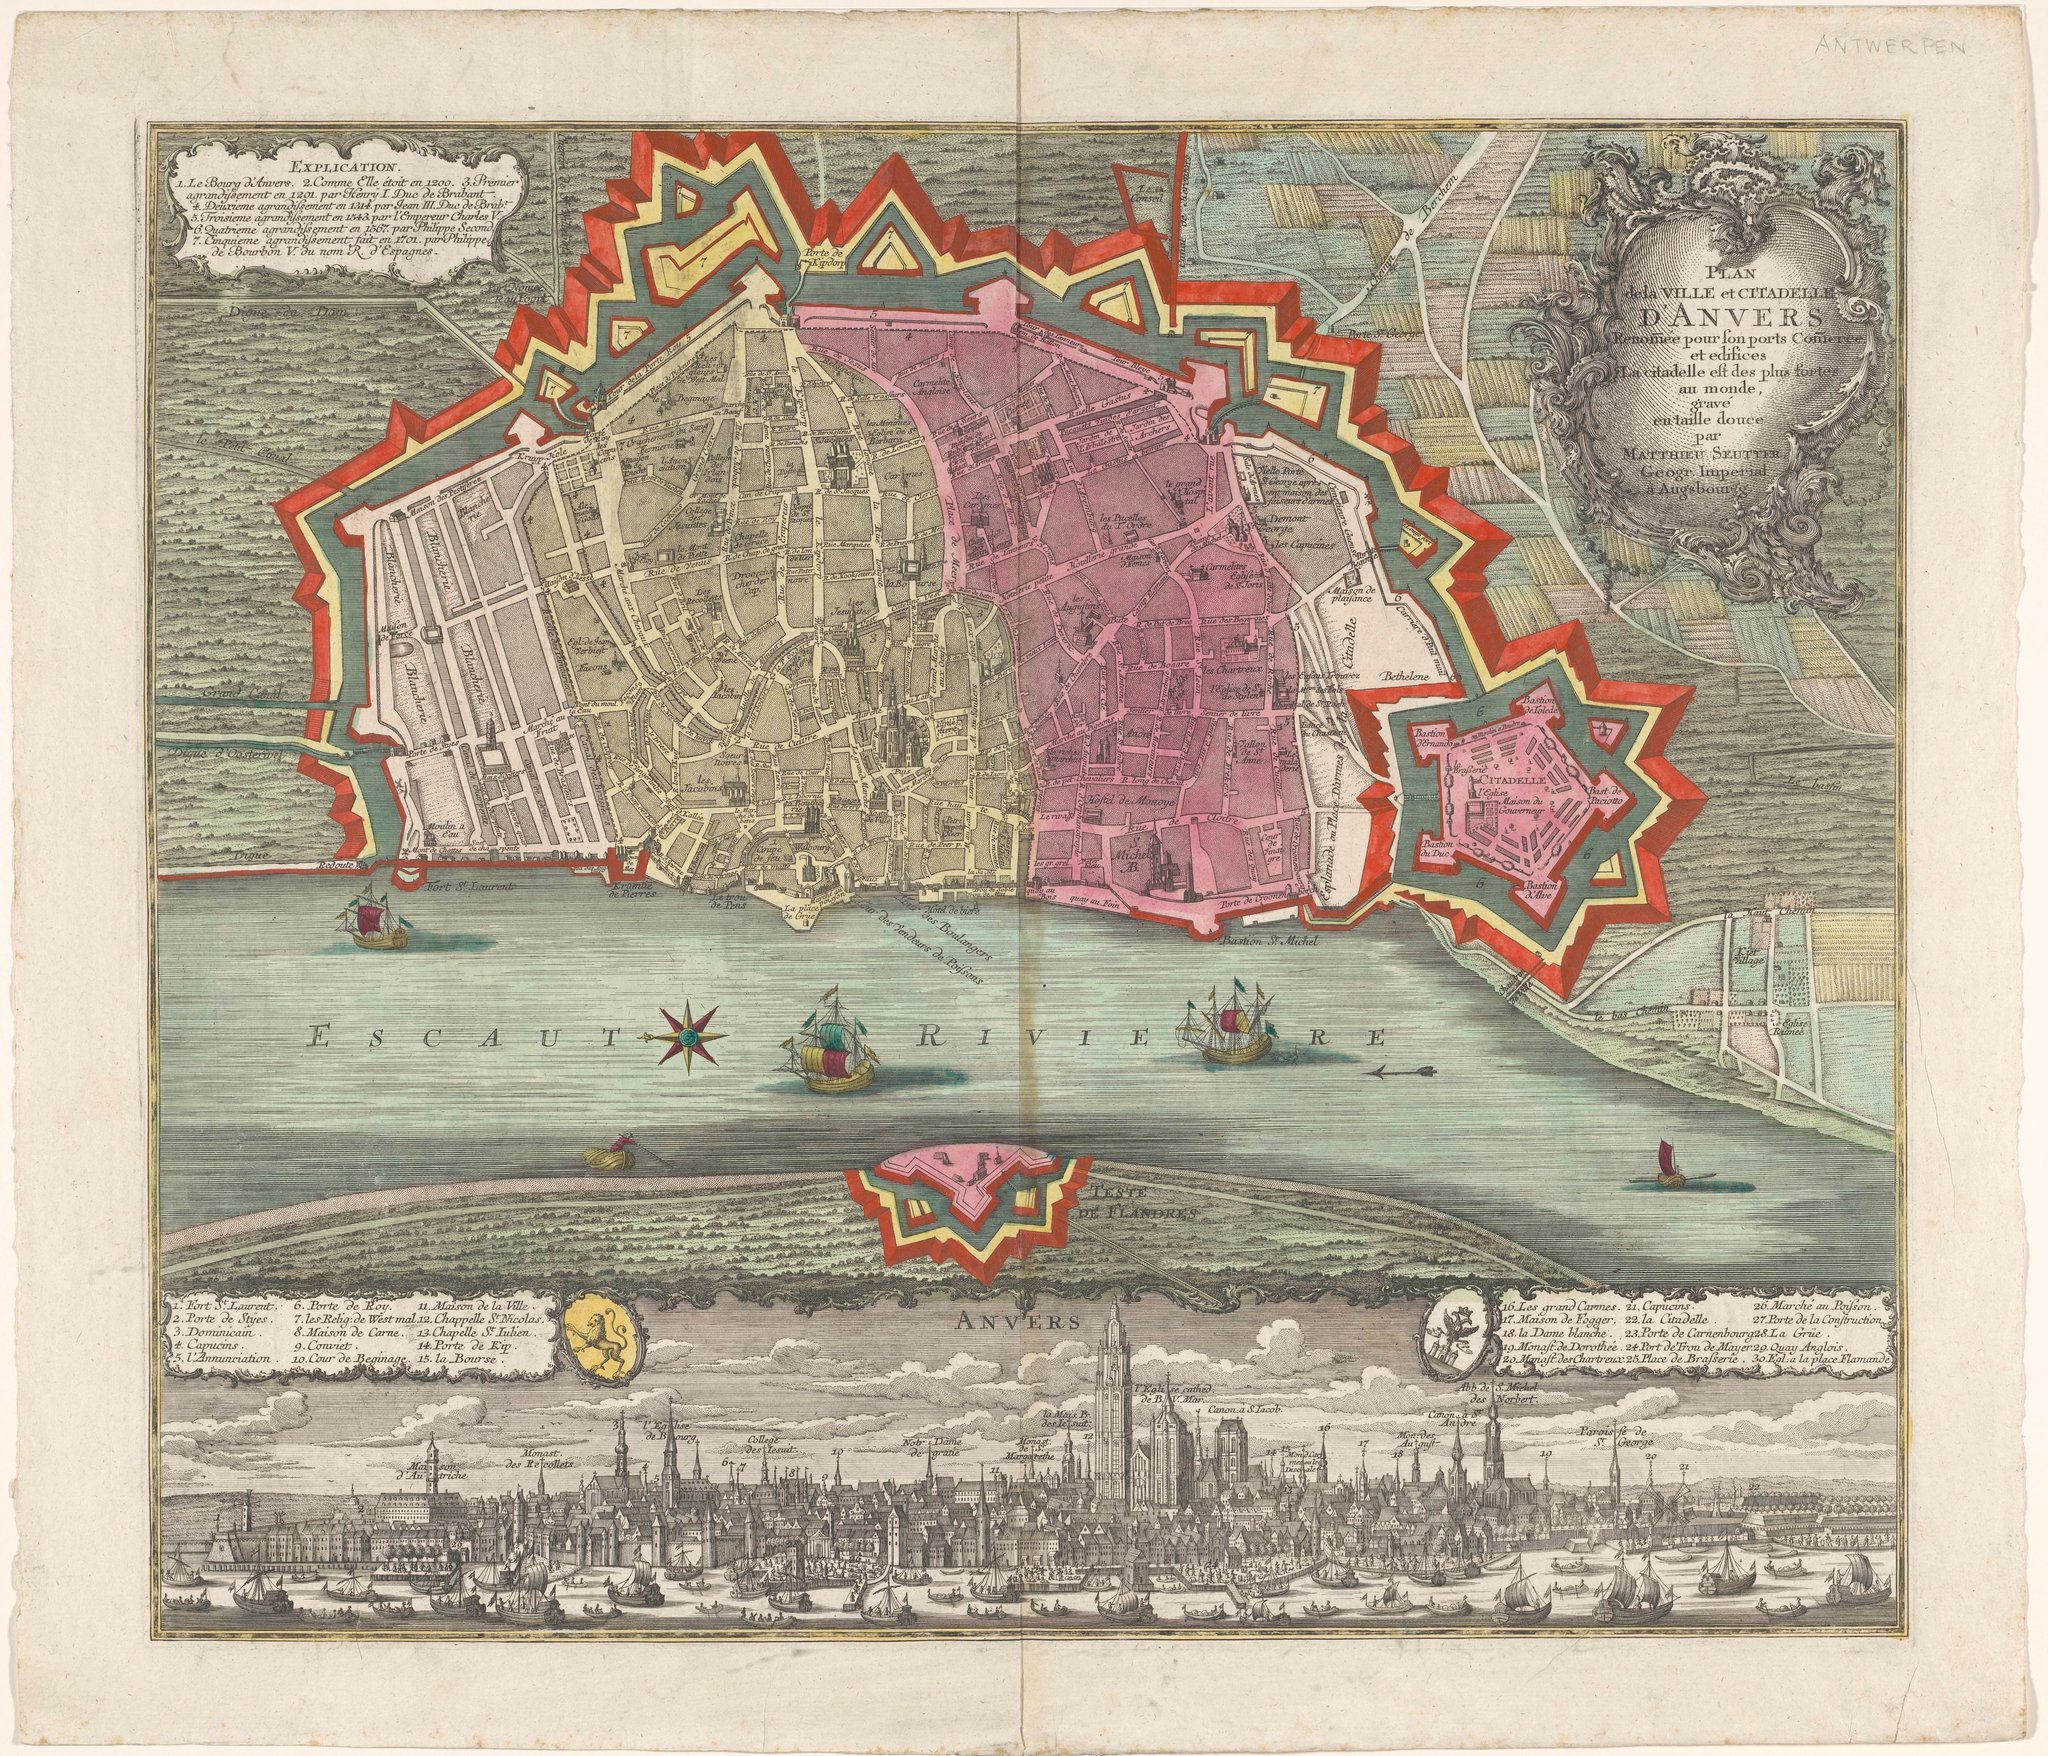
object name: area plan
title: Plattegrond van Antwerpen met stadsgezicht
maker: matthaeus seutter (iii)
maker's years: 1678-1757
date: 1707-1757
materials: paper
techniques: engraving, etching, hand coloring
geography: augsburg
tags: maps of separate countries or regions, fortified city, maps of cities, coat of arms (as symbol of the state, etc.) (+ province; provincial), prospect of city, town panorama, silhouette of city, antwerp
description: Plattegrond van Antwerpen met gebouwen in vogelvluchtperspectief. Rechtsboven de titelcartouche. Linksboven een legenda 1-7. Onder de plattegrond een gezicht op Antwerpen vanaf de Schelde met linksboven een legenda 1-15 met daarnaast het wapen van Brabant, en rechtsboven een legenda 16-30 met daarnaast het wapen van het markgraafschap Antwerpen.